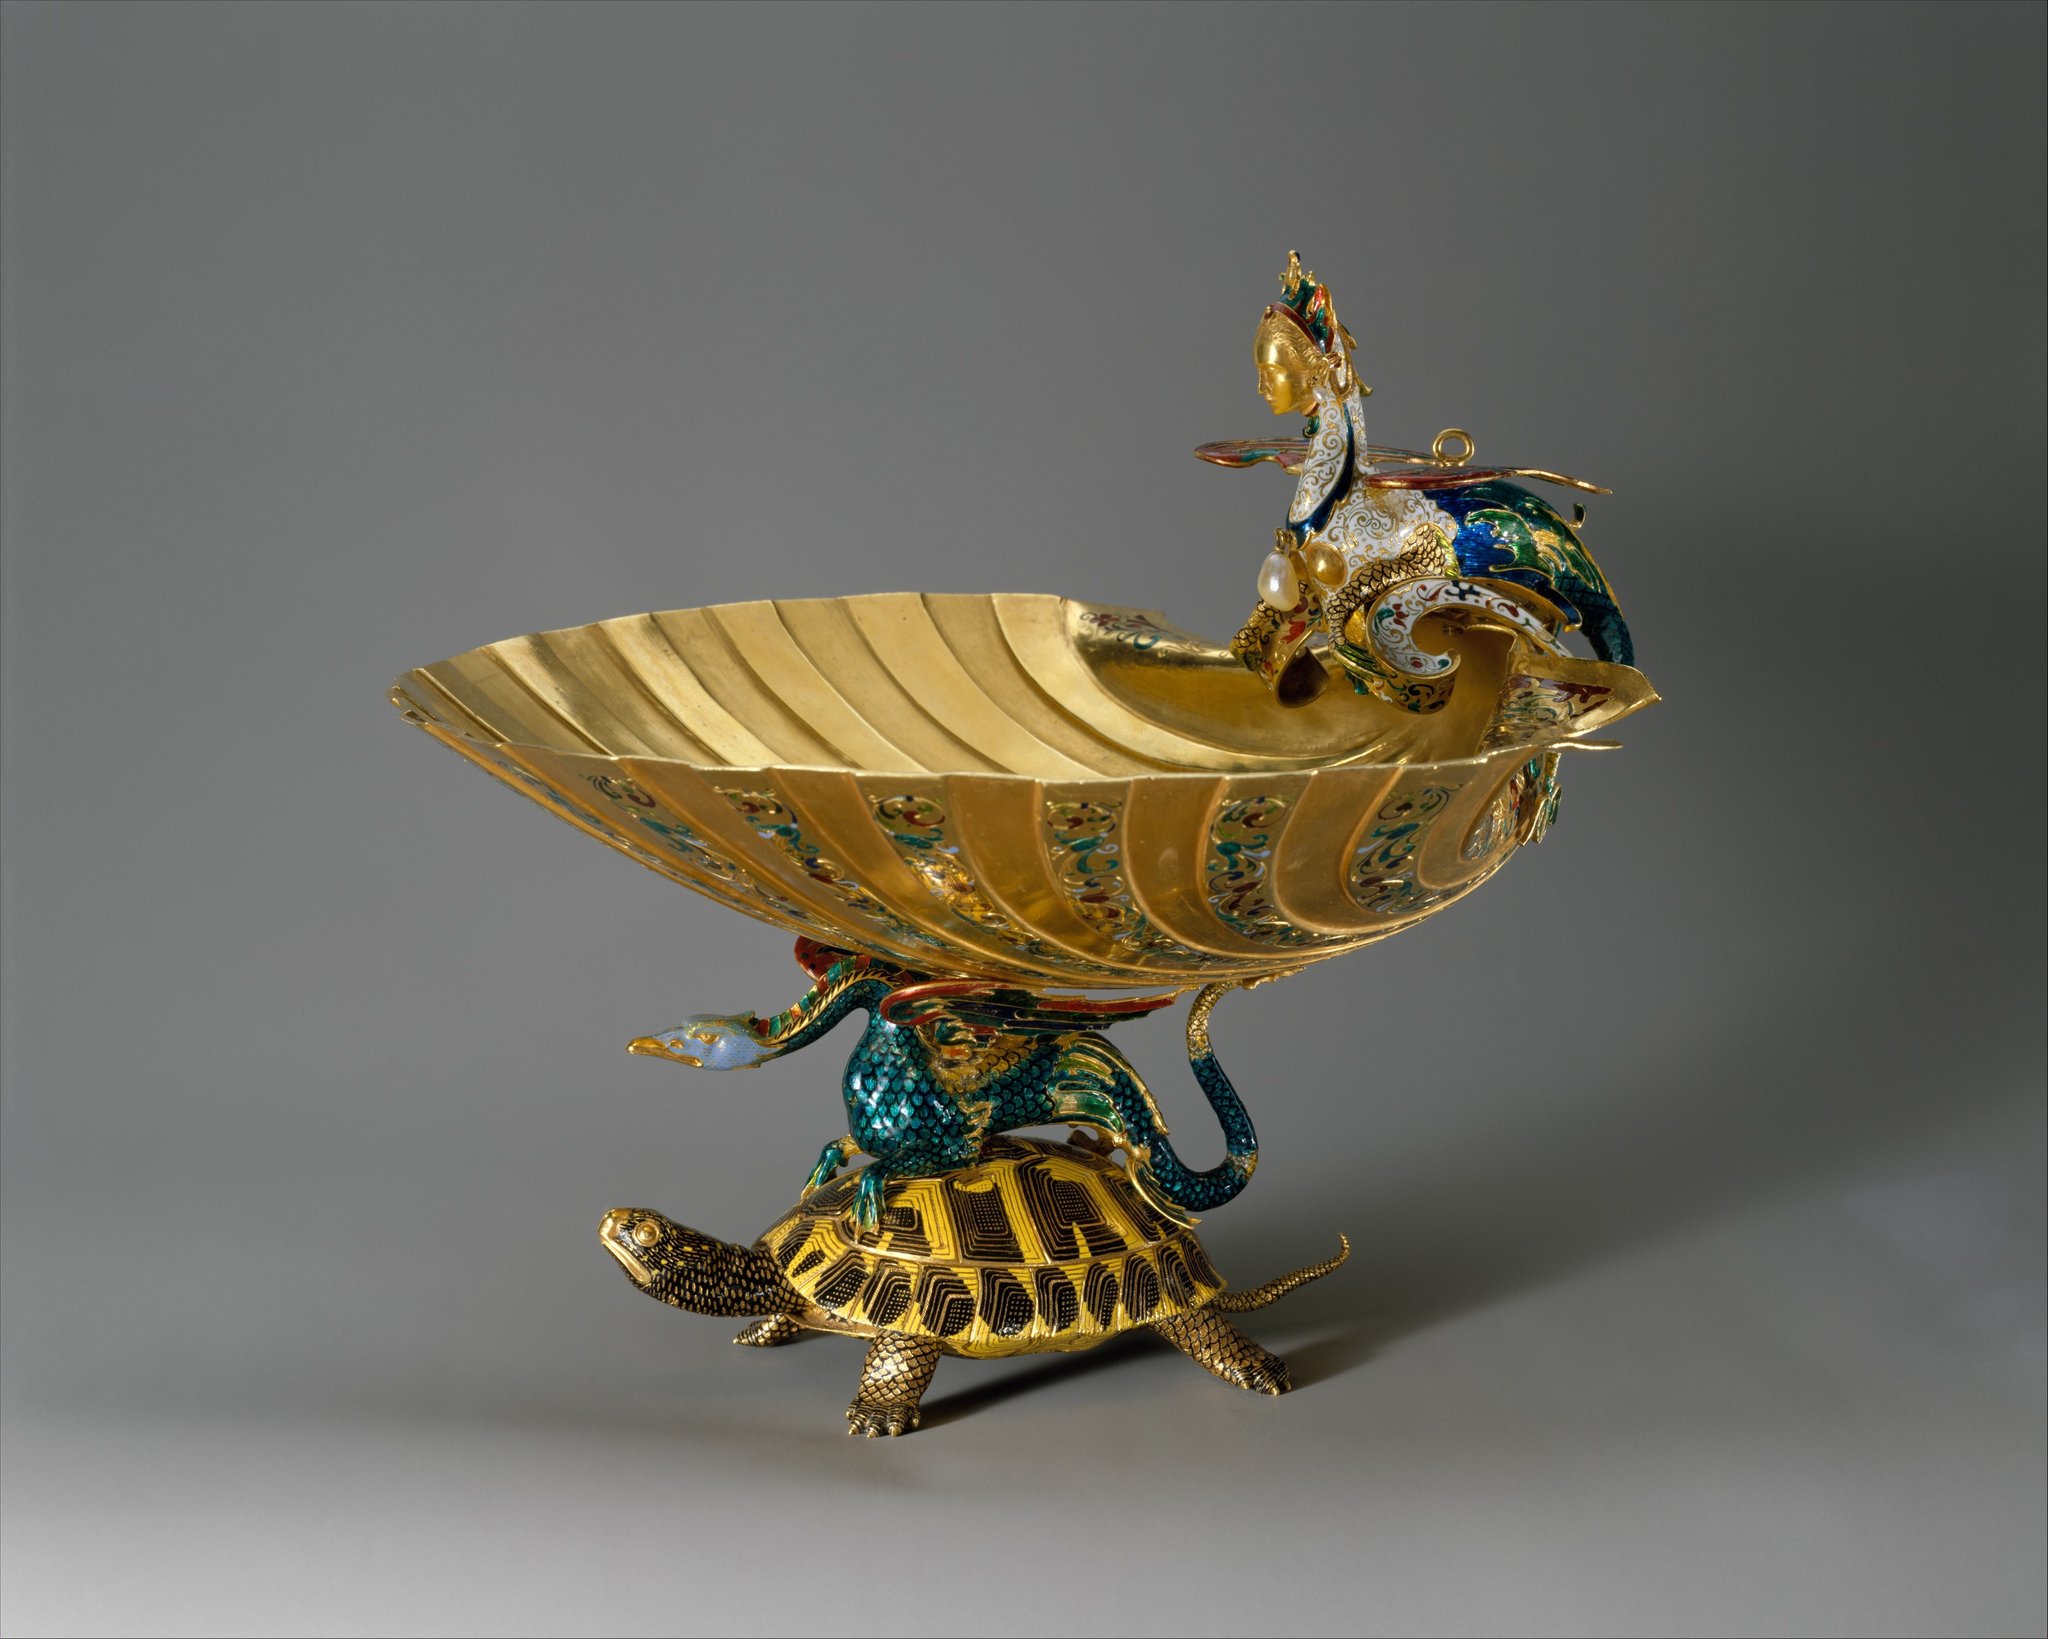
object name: cup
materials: gold, pearl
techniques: enamel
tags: dragons,turtles,shells,sirens